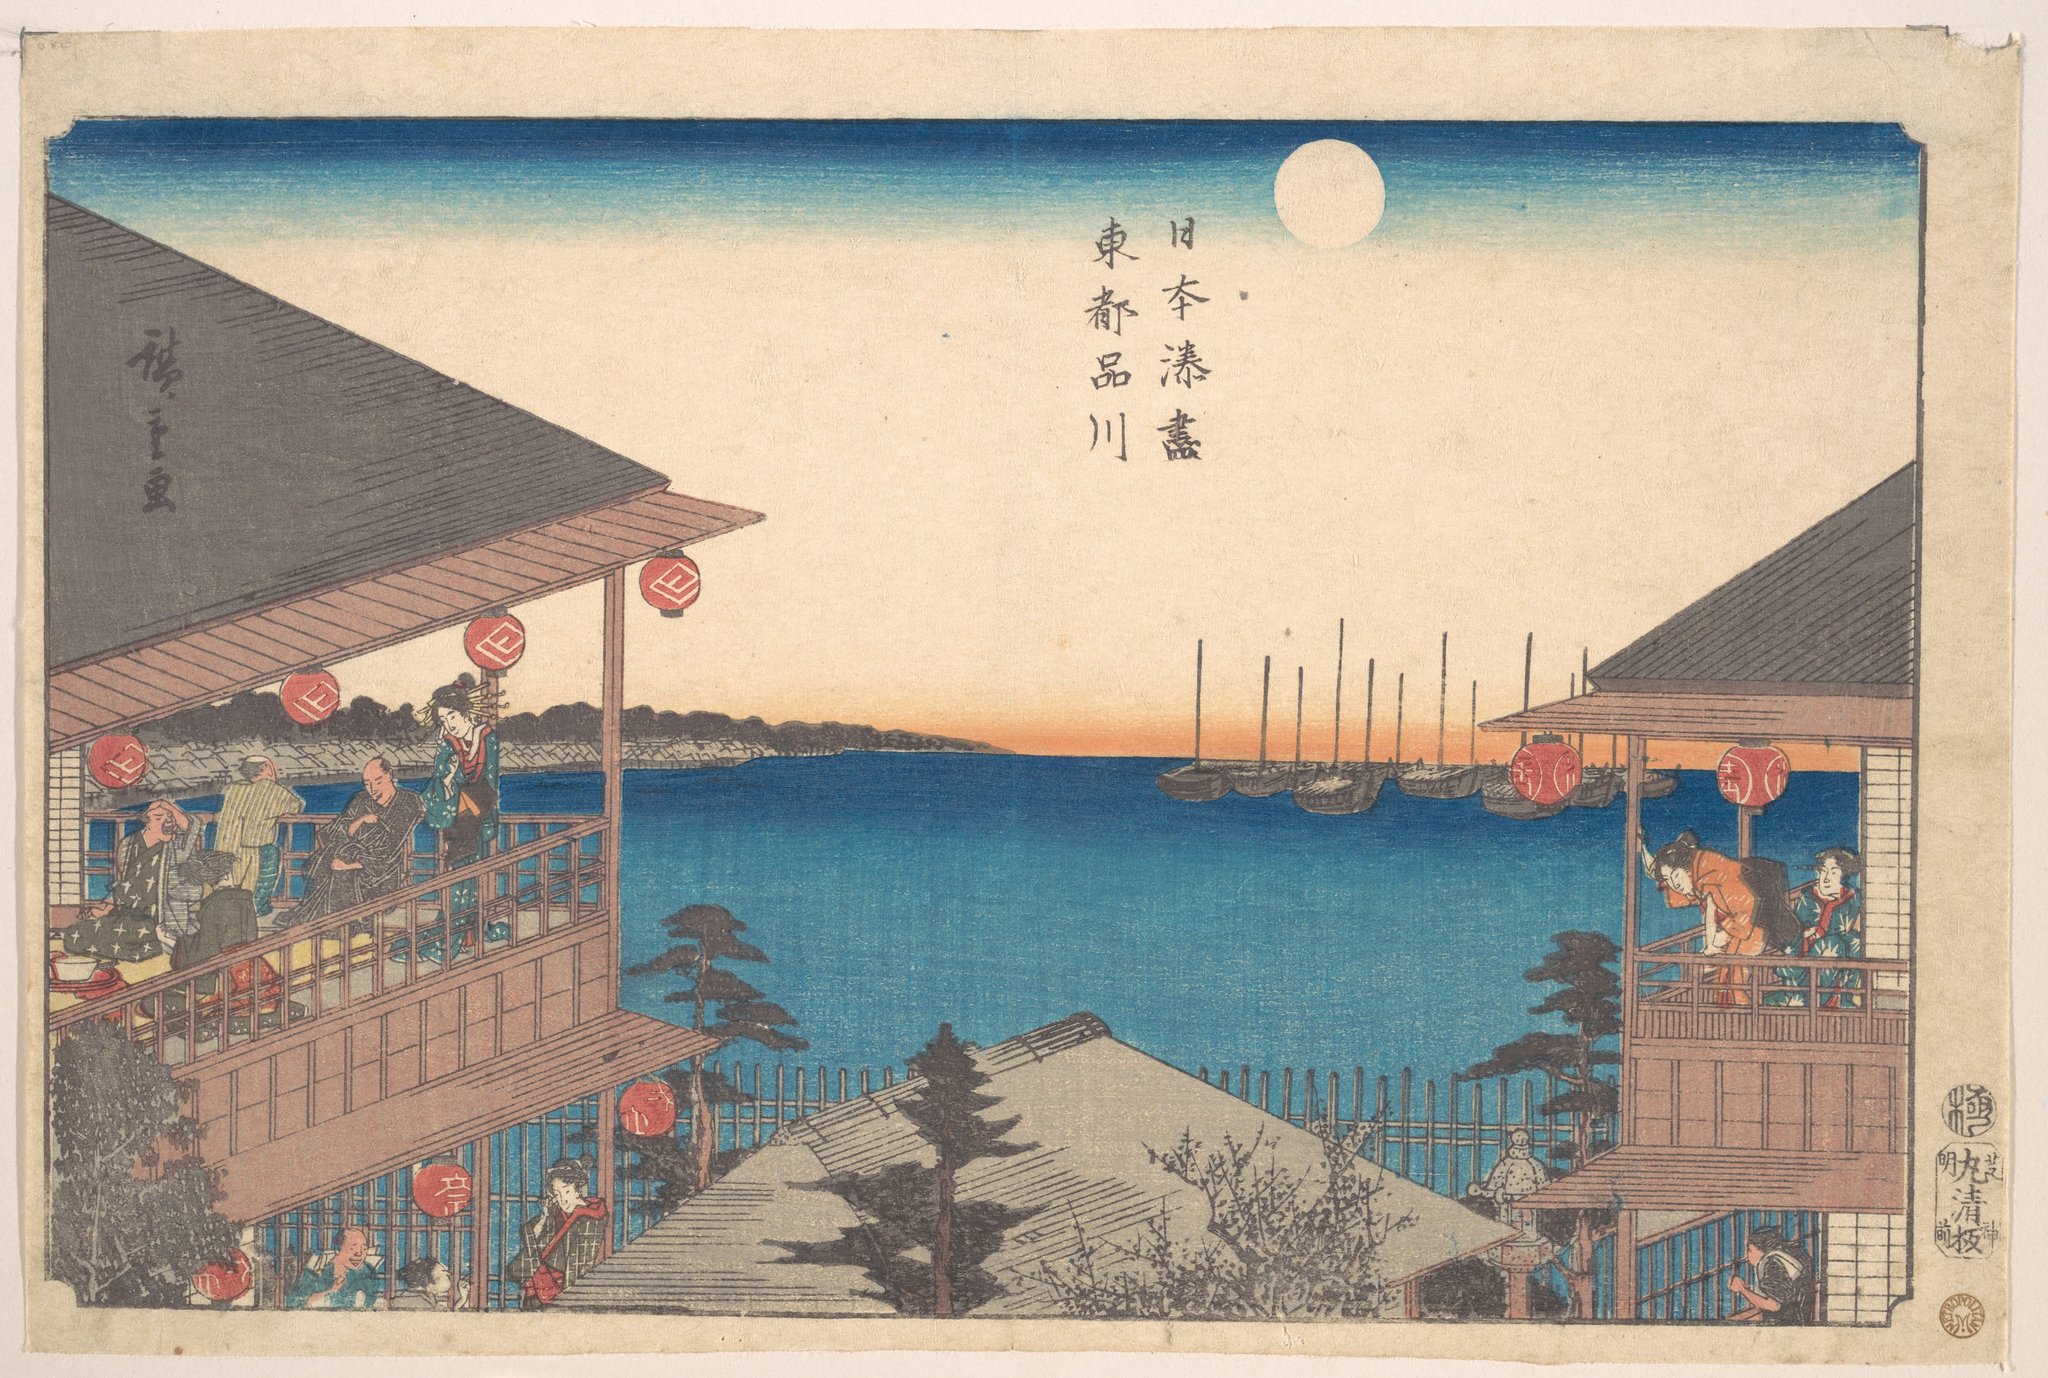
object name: print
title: Toto, Shinagawa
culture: japanese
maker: utagawa hiroshige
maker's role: artist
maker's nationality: japanese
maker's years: 1797-1858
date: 1838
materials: ink, paper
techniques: woodblock print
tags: balconies,men,women,boats